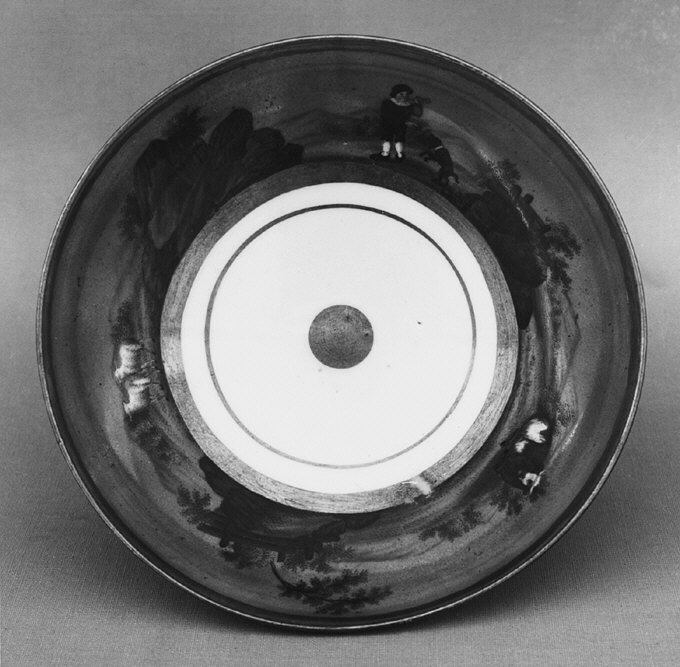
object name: saucer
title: Saucer (one of six) (part of a set)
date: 1820-1830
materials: hard paste porcelain